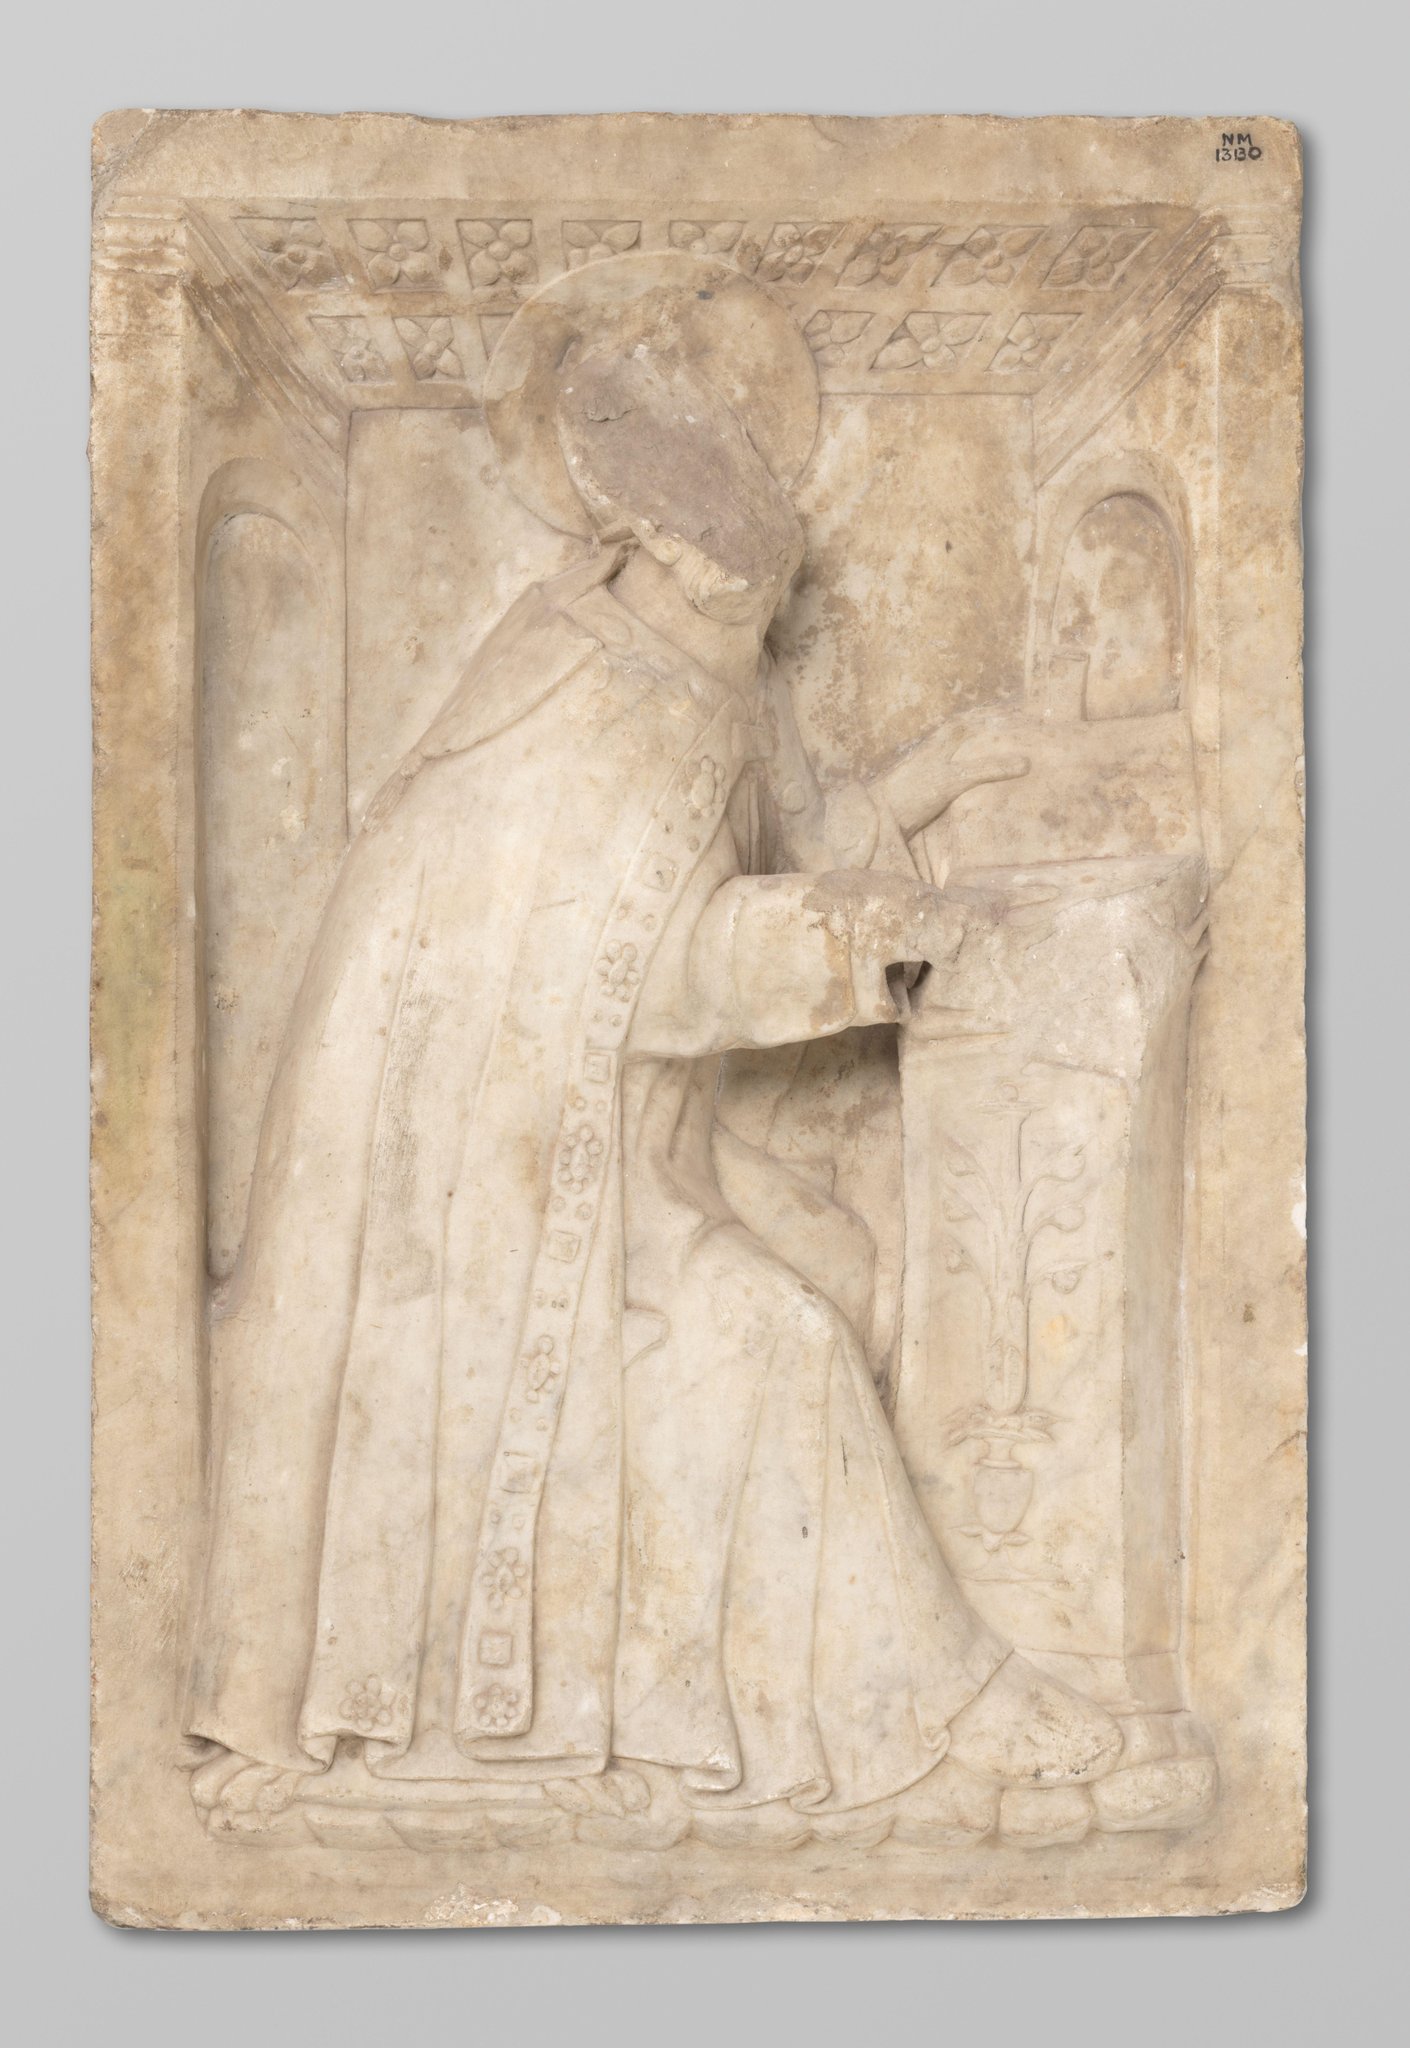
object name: sculpture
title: Een heilige bisschop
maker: Anonymous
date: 1475-1500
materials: marble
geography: northern italy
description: De bisschop zit in vol ornaat in een vertrek voor een lessenaar, waarop een boek ligt, dat hij met beide handen openhoudt. Achter zijn hoofd een nimbus. De lessenaar is versierd met kandelaberornament.